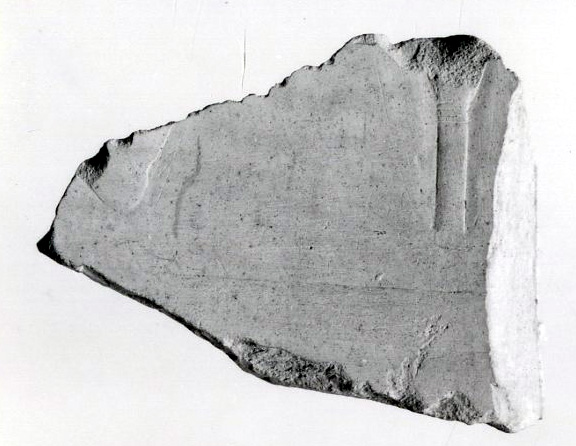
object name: relief fragment, tomb of meketre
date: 1981-1975 BCE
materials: limestone, paint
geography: egypt